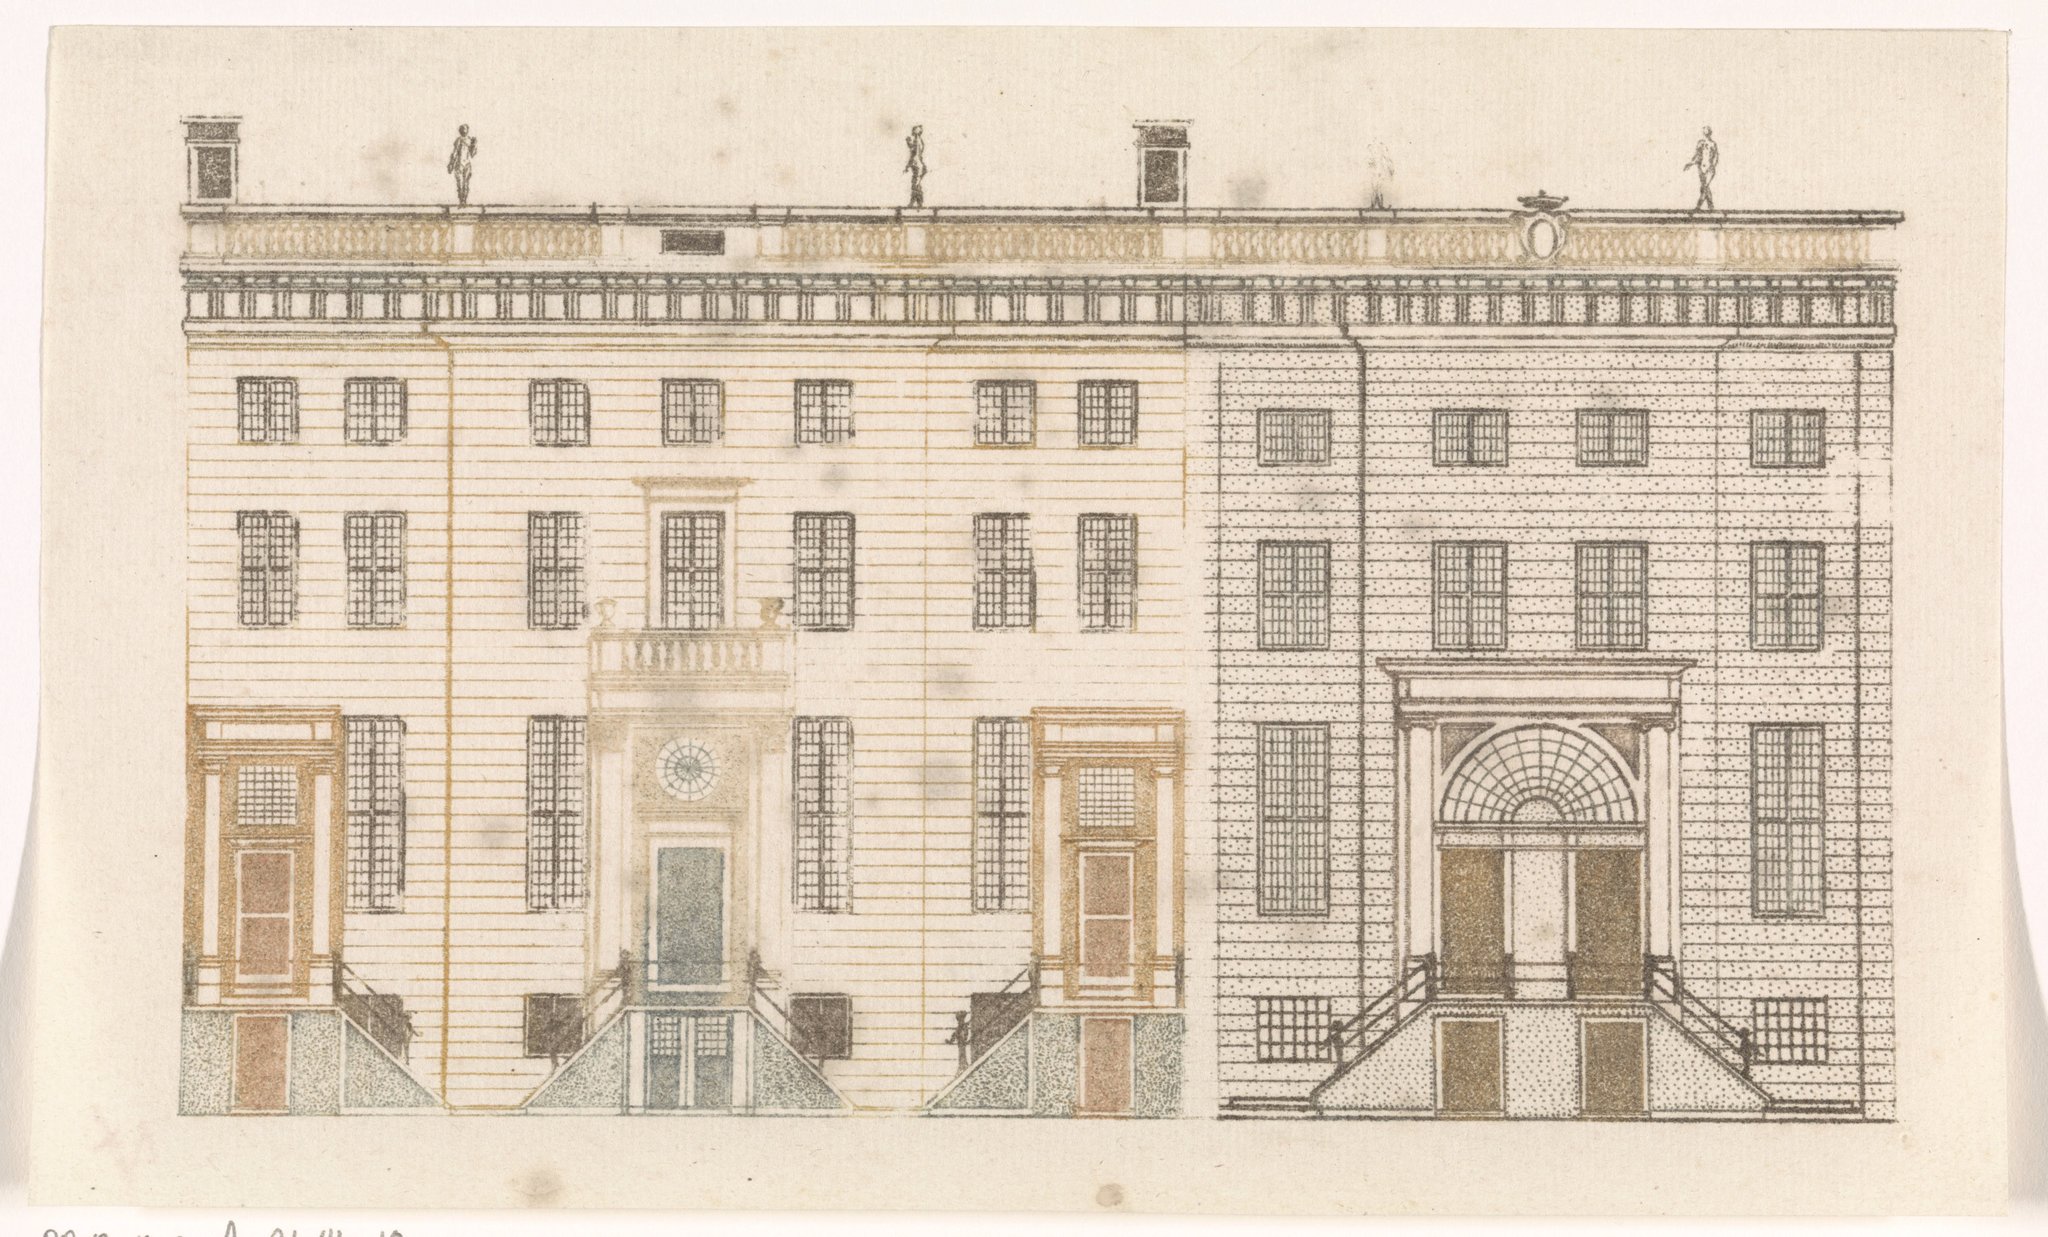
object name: print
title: Amsterdamse grachtenhuizen aan de Keizersgracht 738-730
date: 1696-1706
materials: paper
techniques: etching, lithography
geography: amsterdam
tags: the usual house or row of houses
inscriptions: collector's mark: Lugt 2228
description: Prent mogelijk gebruikt in: Het Stadhuys van Amsterdam beneffenis verscheyde van de grooste en nieuwste gebouwe. Nieuwelycks uytgegeven door Cornelis Danckerts voor aen op de Nieuwendyck inde Atlas tot Amsterdam met Previlegie. Amsterdam: Cornelis Danckerts, [1696-1706].